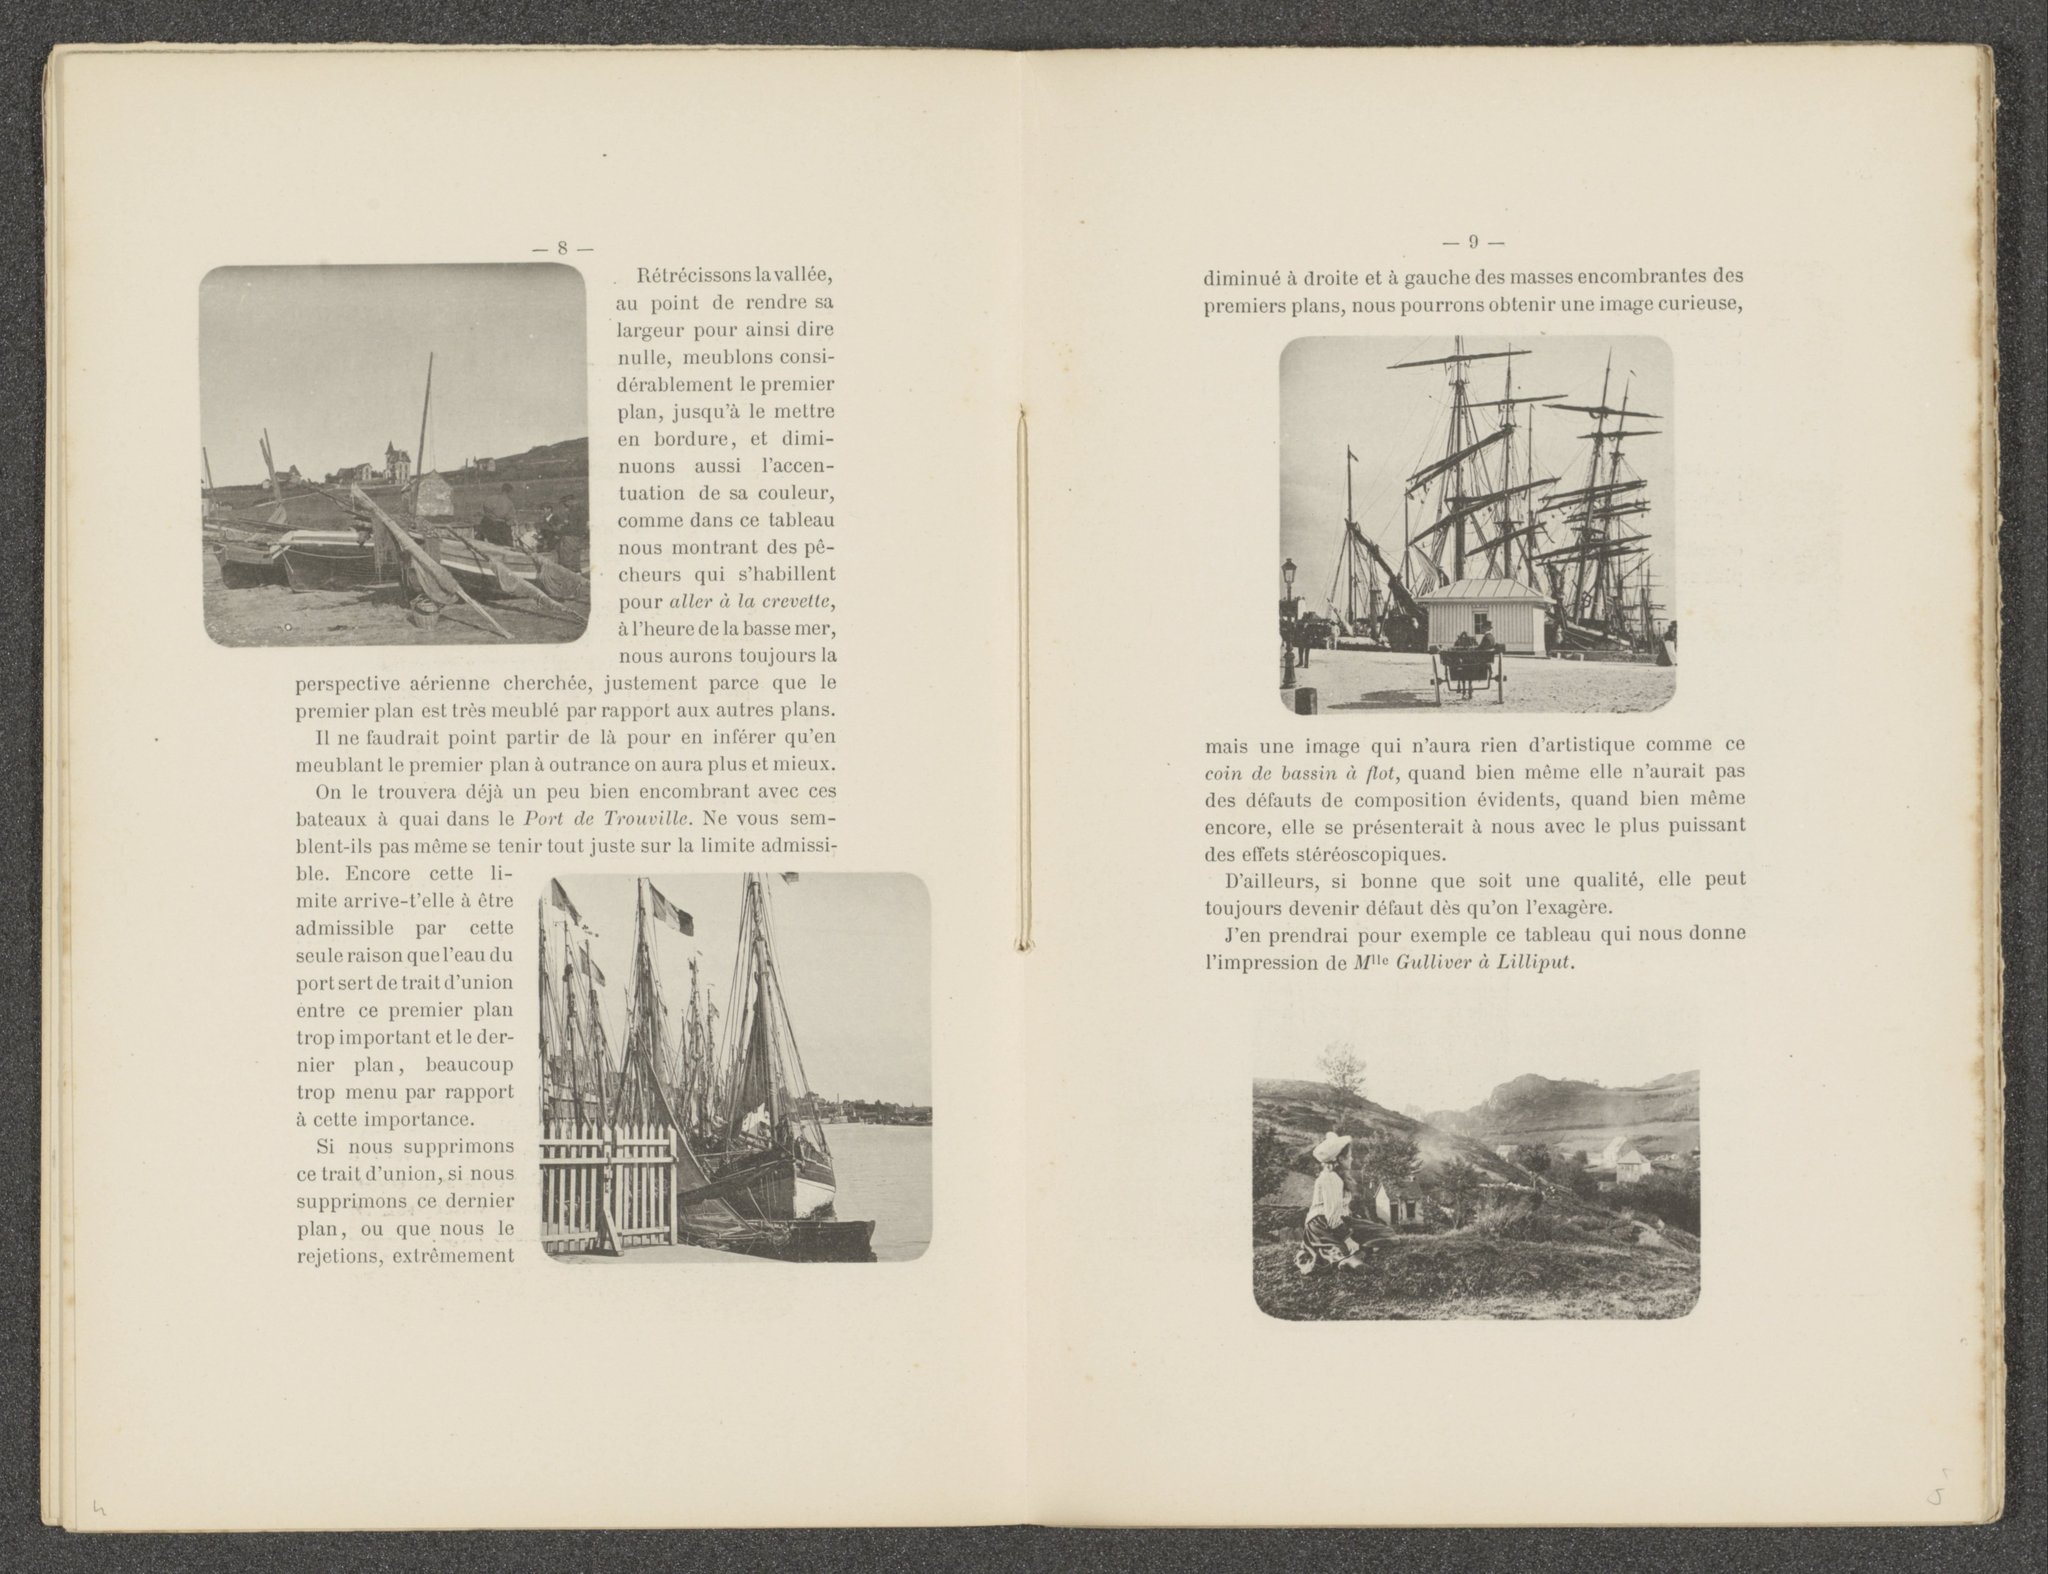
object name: photomechanical print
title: Man op een kar en een zittende vrouw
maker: Anonymous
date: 1886-1896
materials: paper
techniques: photograph, printing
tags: sitting figure, horse, (farm) wagon, freight wagon, cart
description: Boven een man op een paardenkar in een haven, onder een zittende vrouw op een heuvel.